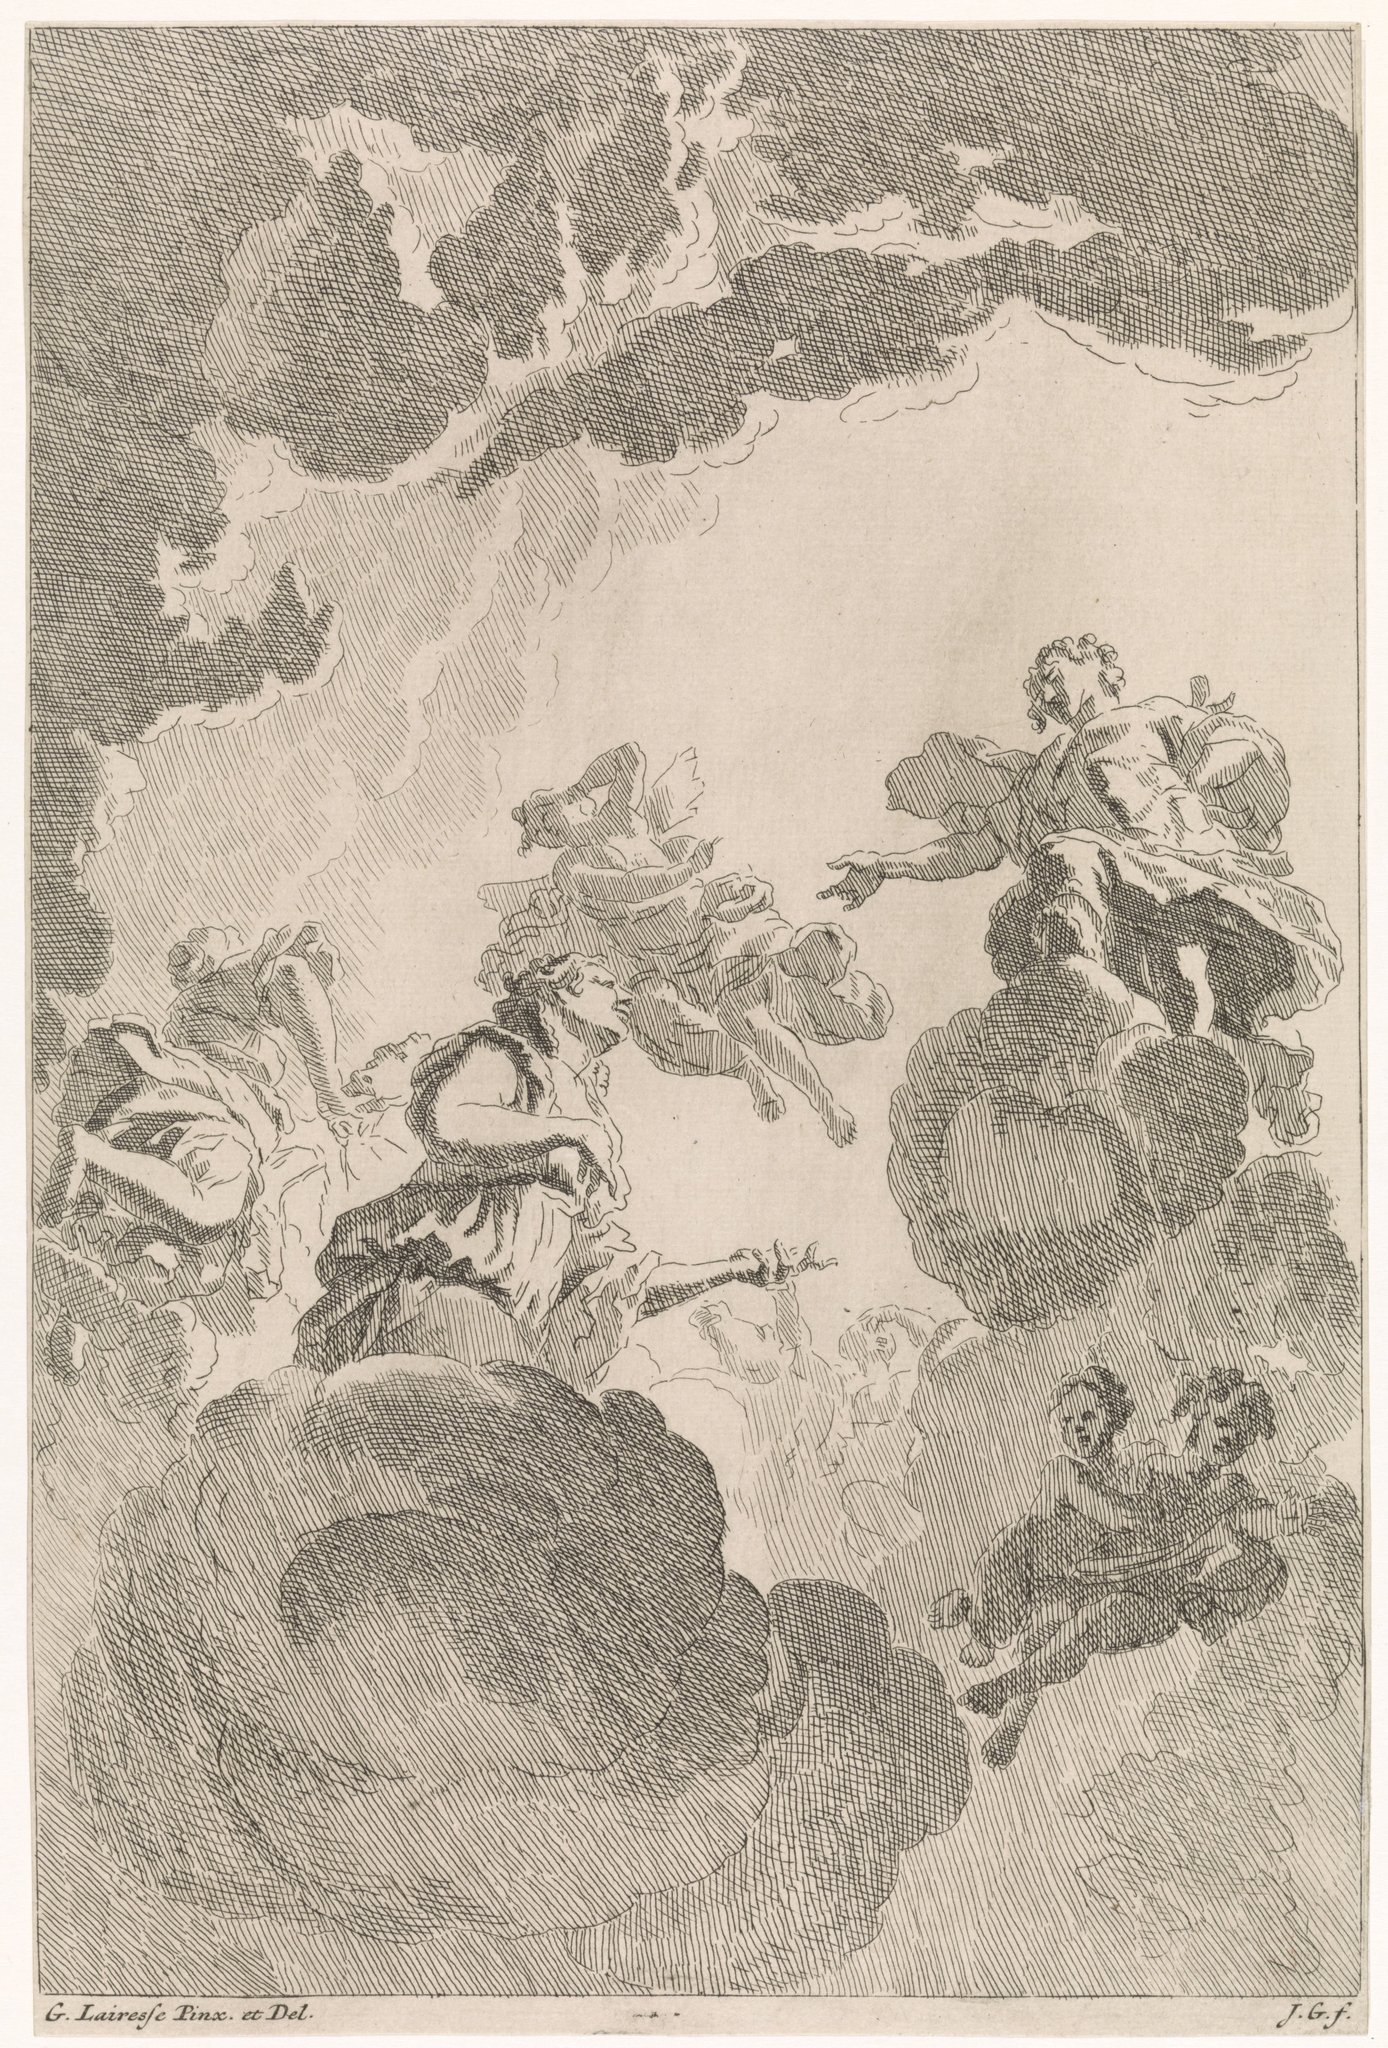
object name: print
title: Bijbelse, mythologische en allegorische voorstellingen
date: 1670-1726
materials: paper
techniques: etching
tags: phaethon asks apollo (sol) for the chariot of the sun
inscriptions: collector's mark: Lugt 240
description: In de wolken vraagt Phaëthon toestemming aan zijn vader om met de zonnewagen te rijden. De prent is naar een verloren plafondschilderij van Gerard de Lairesse en maakt deel uit van een serie met Bijbelse, mythologische en allegorische voorstellingen.